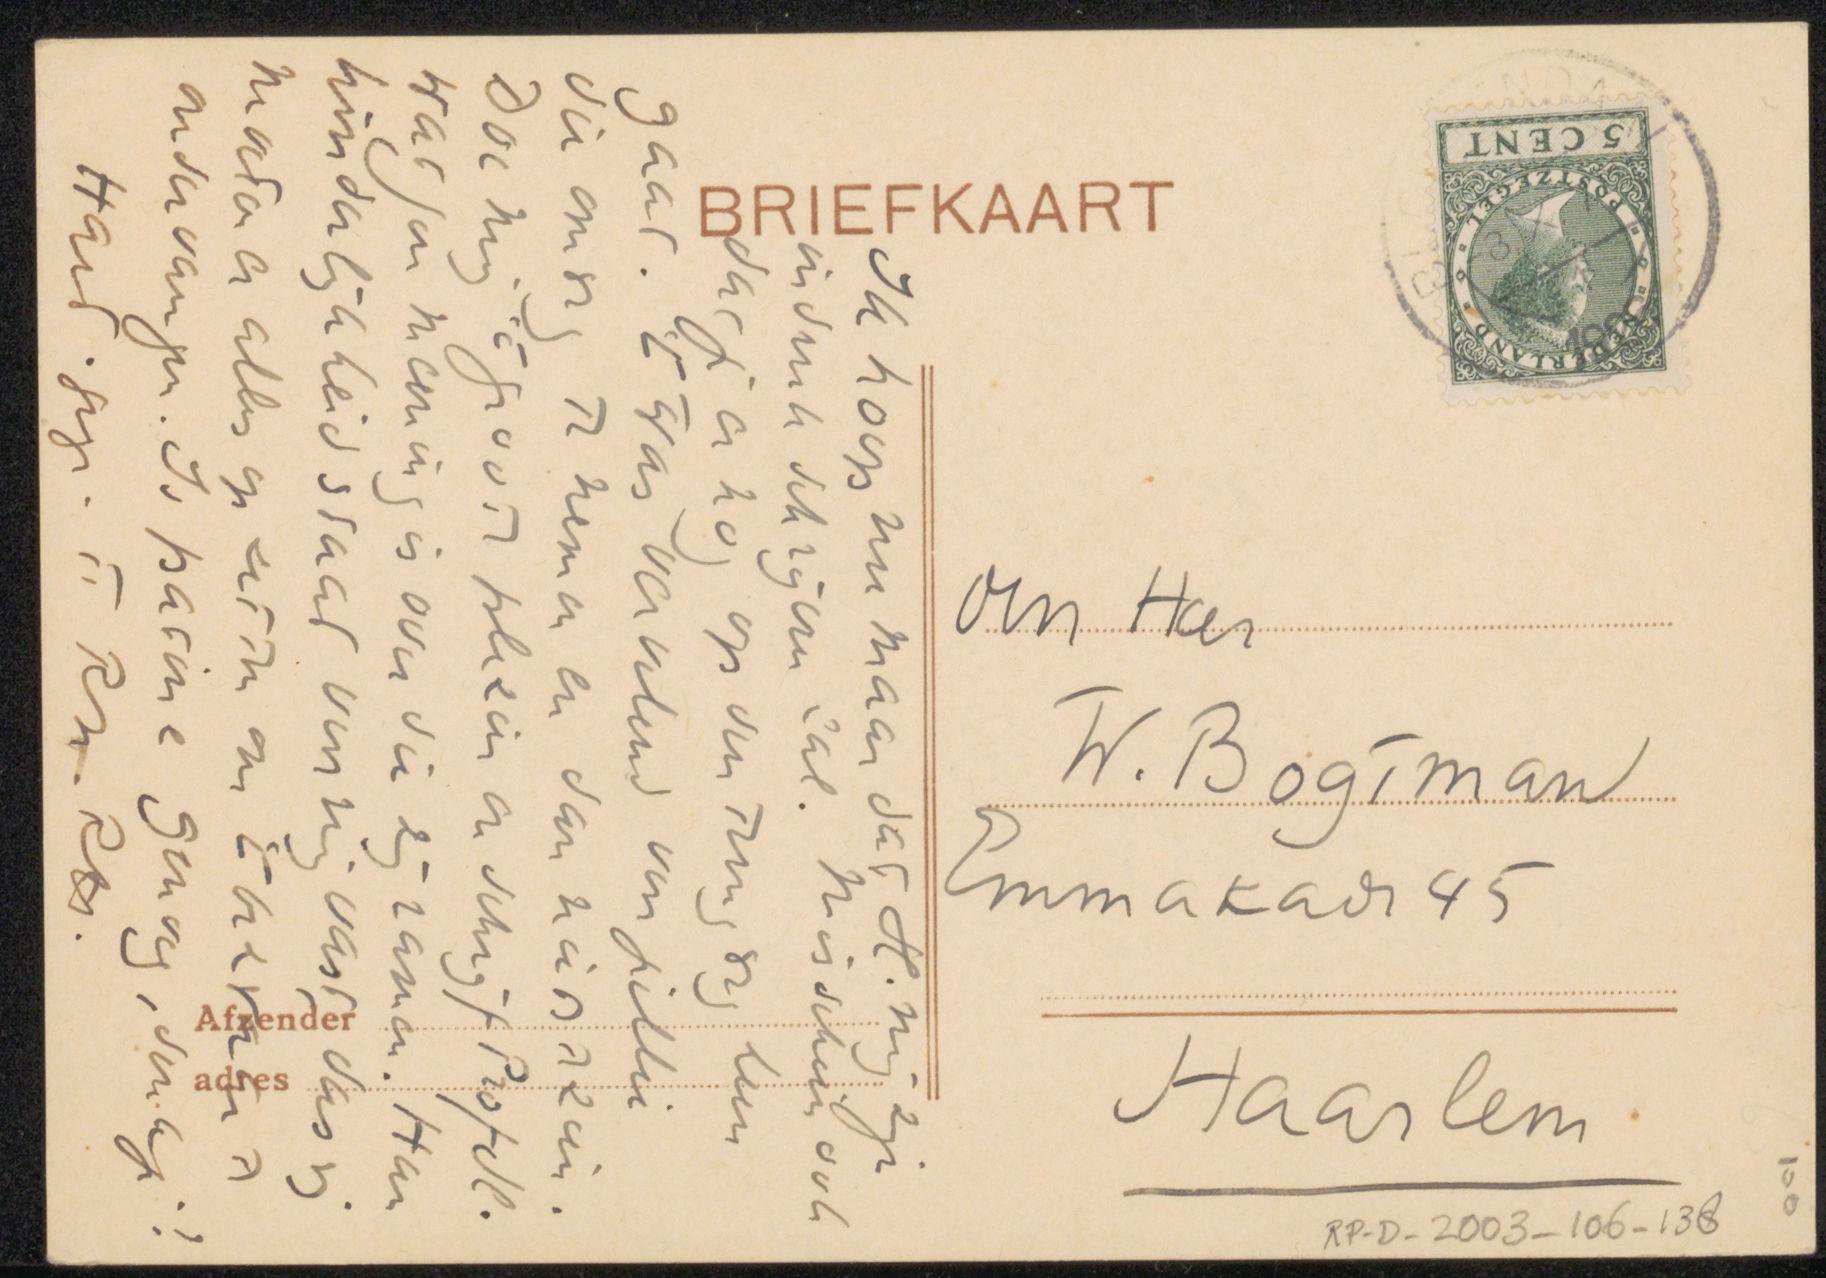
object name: postcard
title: Briefkaart aan Willem Bogtman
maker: richard nicolaüs roland holst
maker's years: 1868-1938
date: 1926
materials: cardboard, ink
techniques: pen, writing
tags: indonesia, willem bogtman, applied arts, arts and crafts; industrial design, diseases